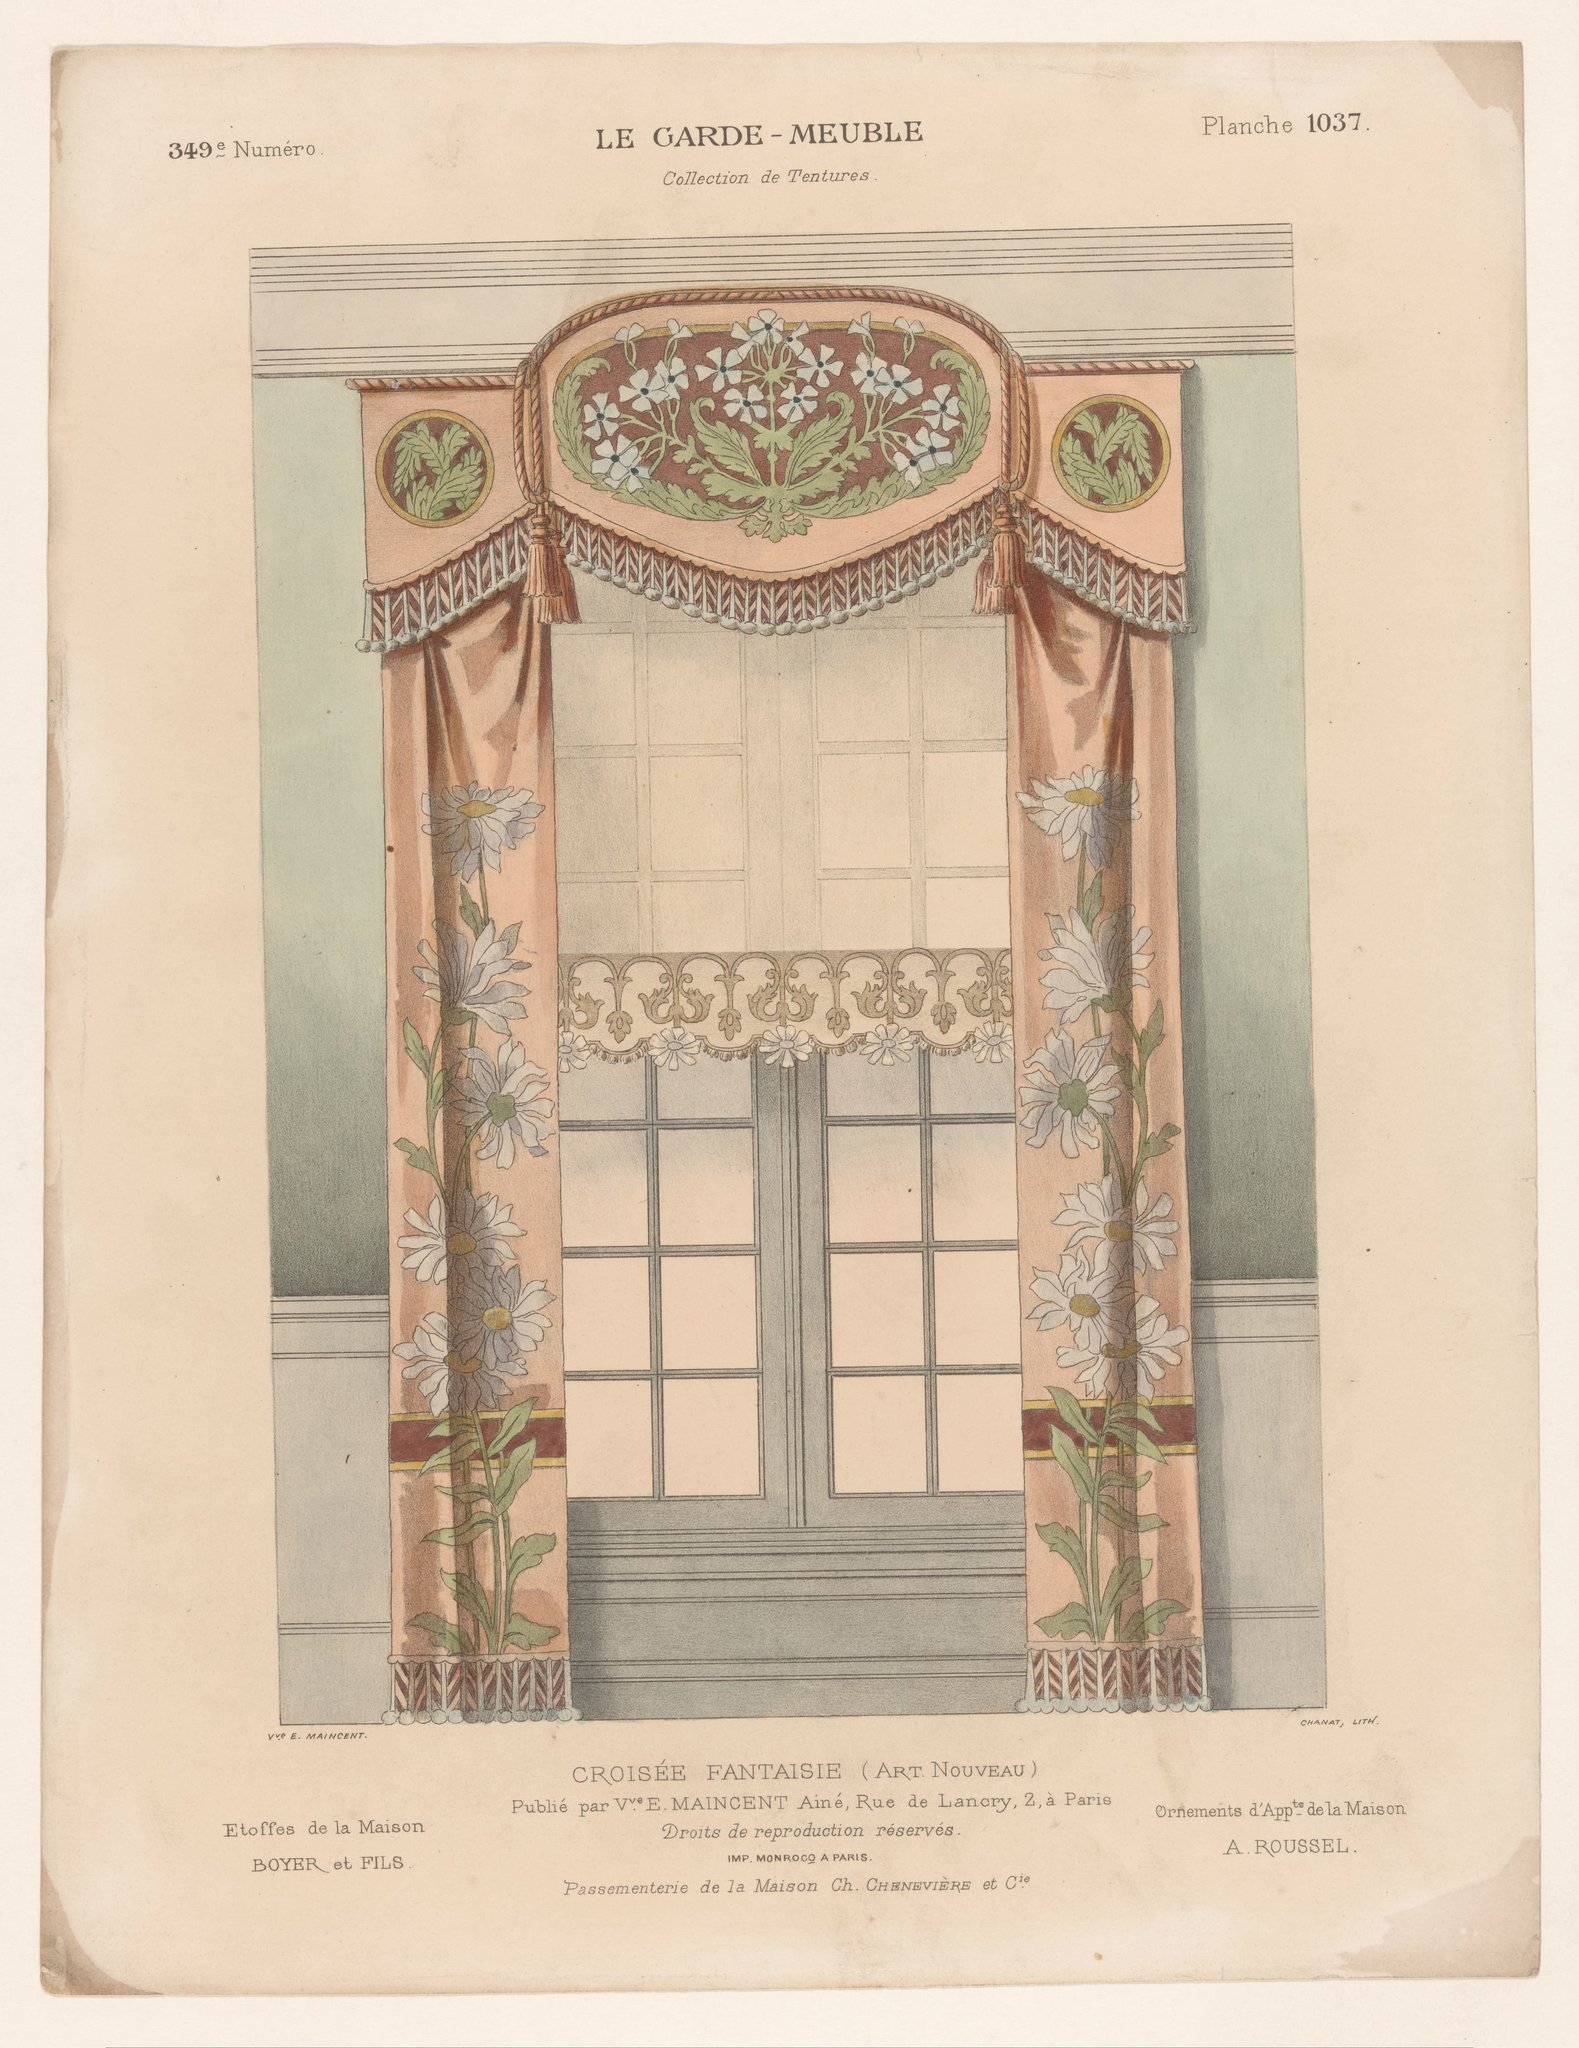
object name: print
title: Le Garde-Meuble / Collection de Tentures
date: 1895-1910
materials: paper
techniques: hand coloring, lithograph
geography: paris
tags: window, hangings and drapery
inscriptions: : ‘Droits de reproduction réservés.’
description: Kruisvenster met gedrapeerde gordijnen in art-nouveaustijl. Prent uit 349e Livraison.